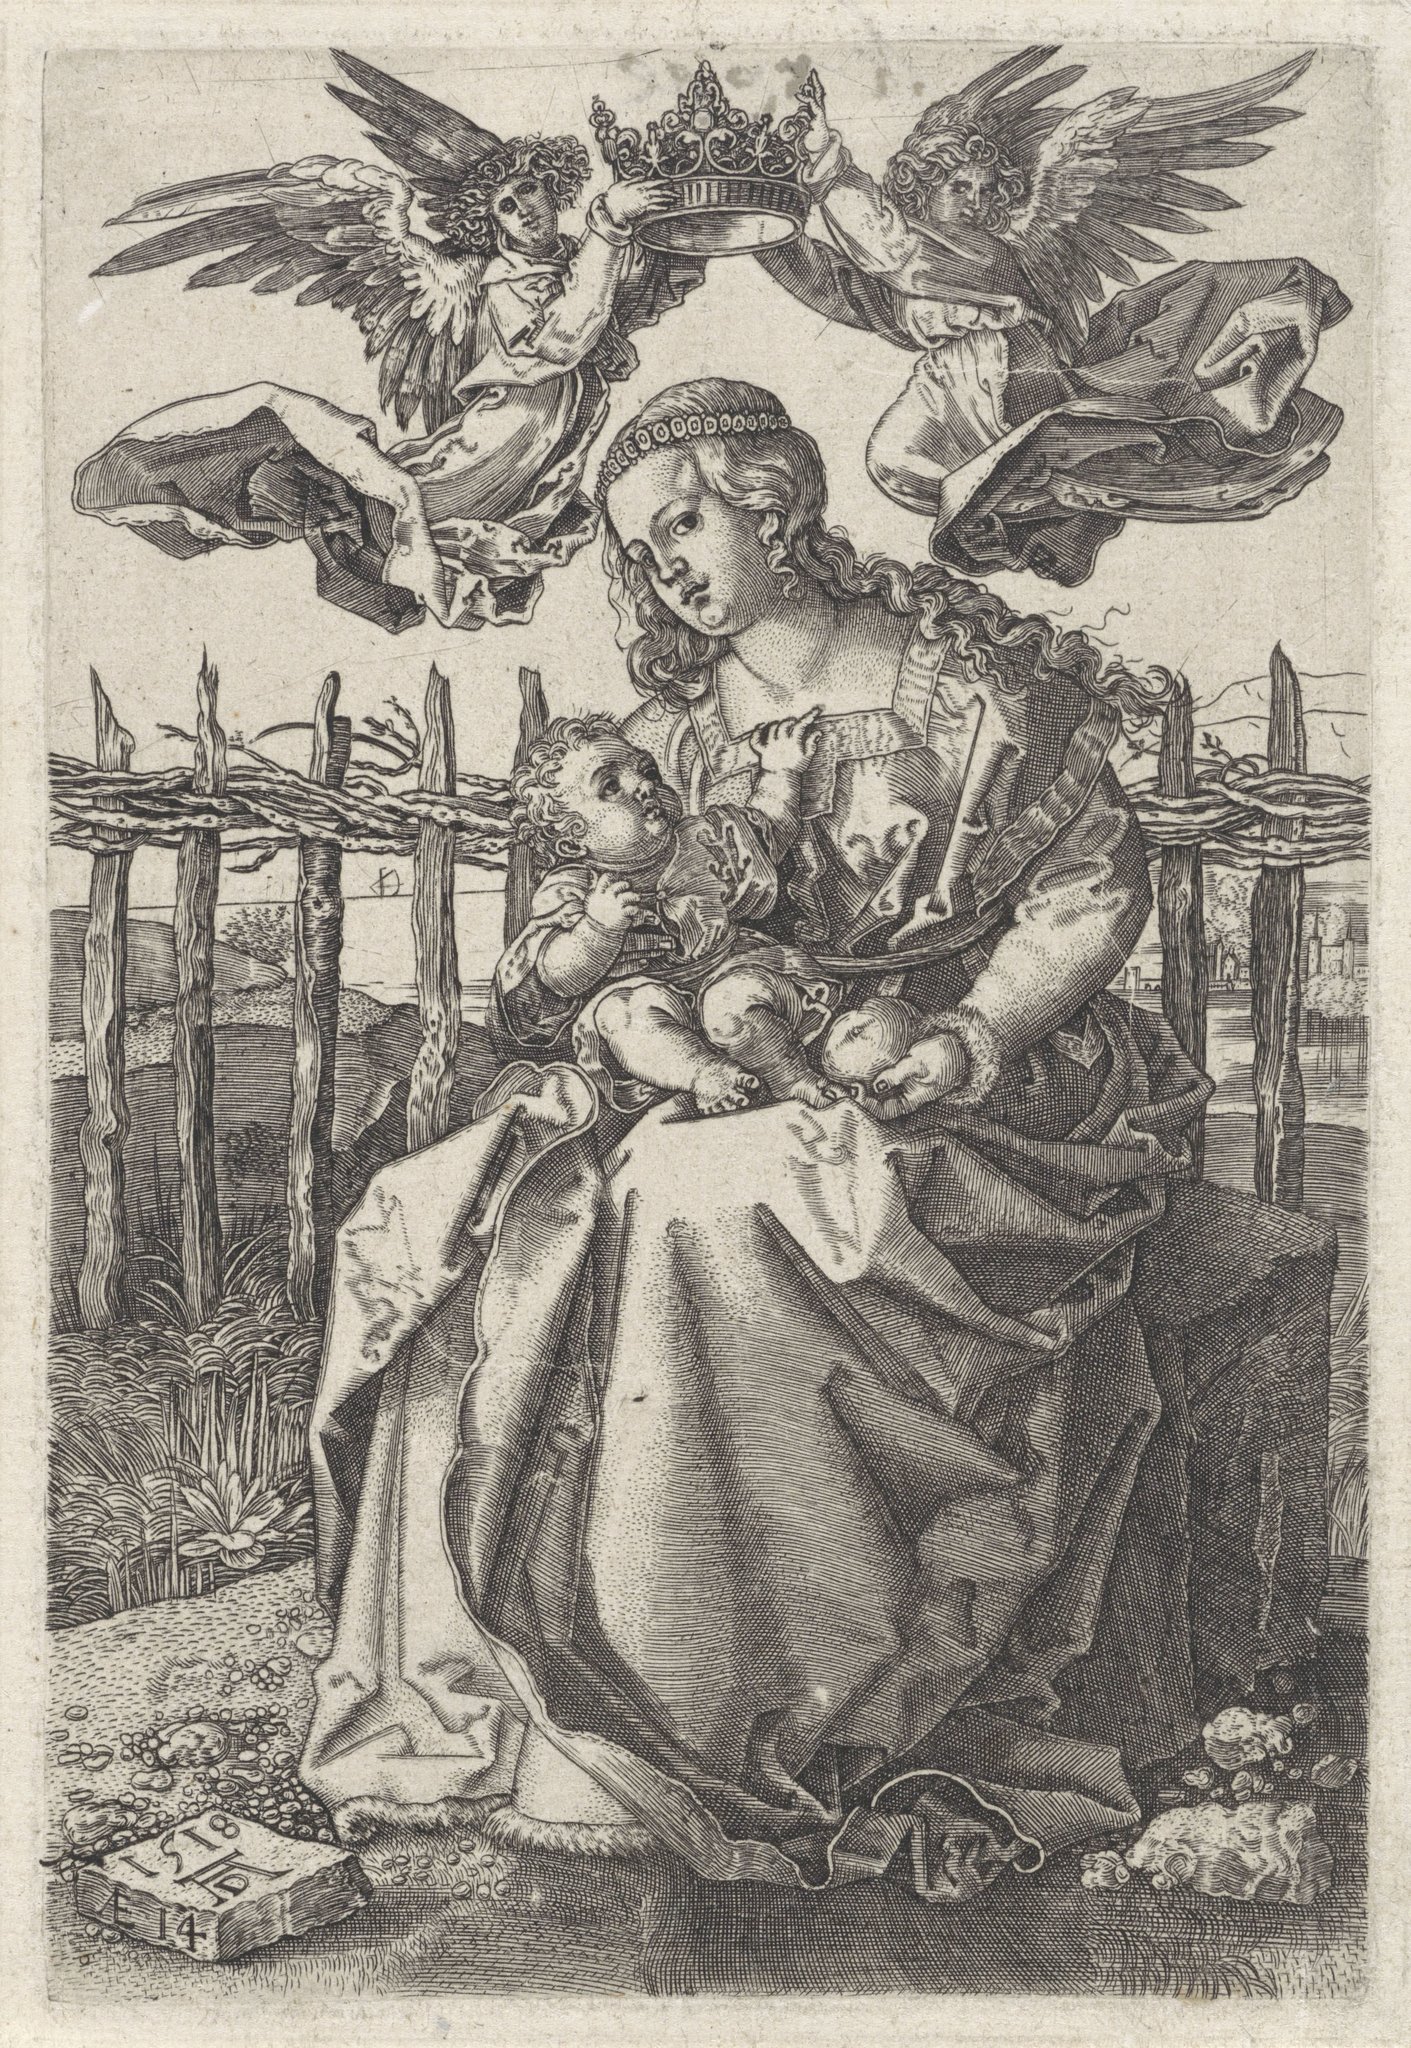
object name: print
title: Maria met Christuskind op schoot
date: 1563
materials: paper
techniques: engraving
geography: antwerp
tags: madonna: mary sitting or enthroned, the christ-child in her lap (or in front of her bosom) (mary sometimes represented half-length), coronation of mary by one or more angels, fence, wall, paling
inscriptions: inscription: ‘k [...]’, collector's mark: Lugt 240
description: Maria zit met het Christuskind op schoot op een steen voor een houten hek. In haar hand houdt ze een vrucht. Twee engelen zetten haar een kroon op. Links op de voorgrond een steen gemerkt met "Æ 14", het monogram van Albrecht Dürer en de datering van diens prent.